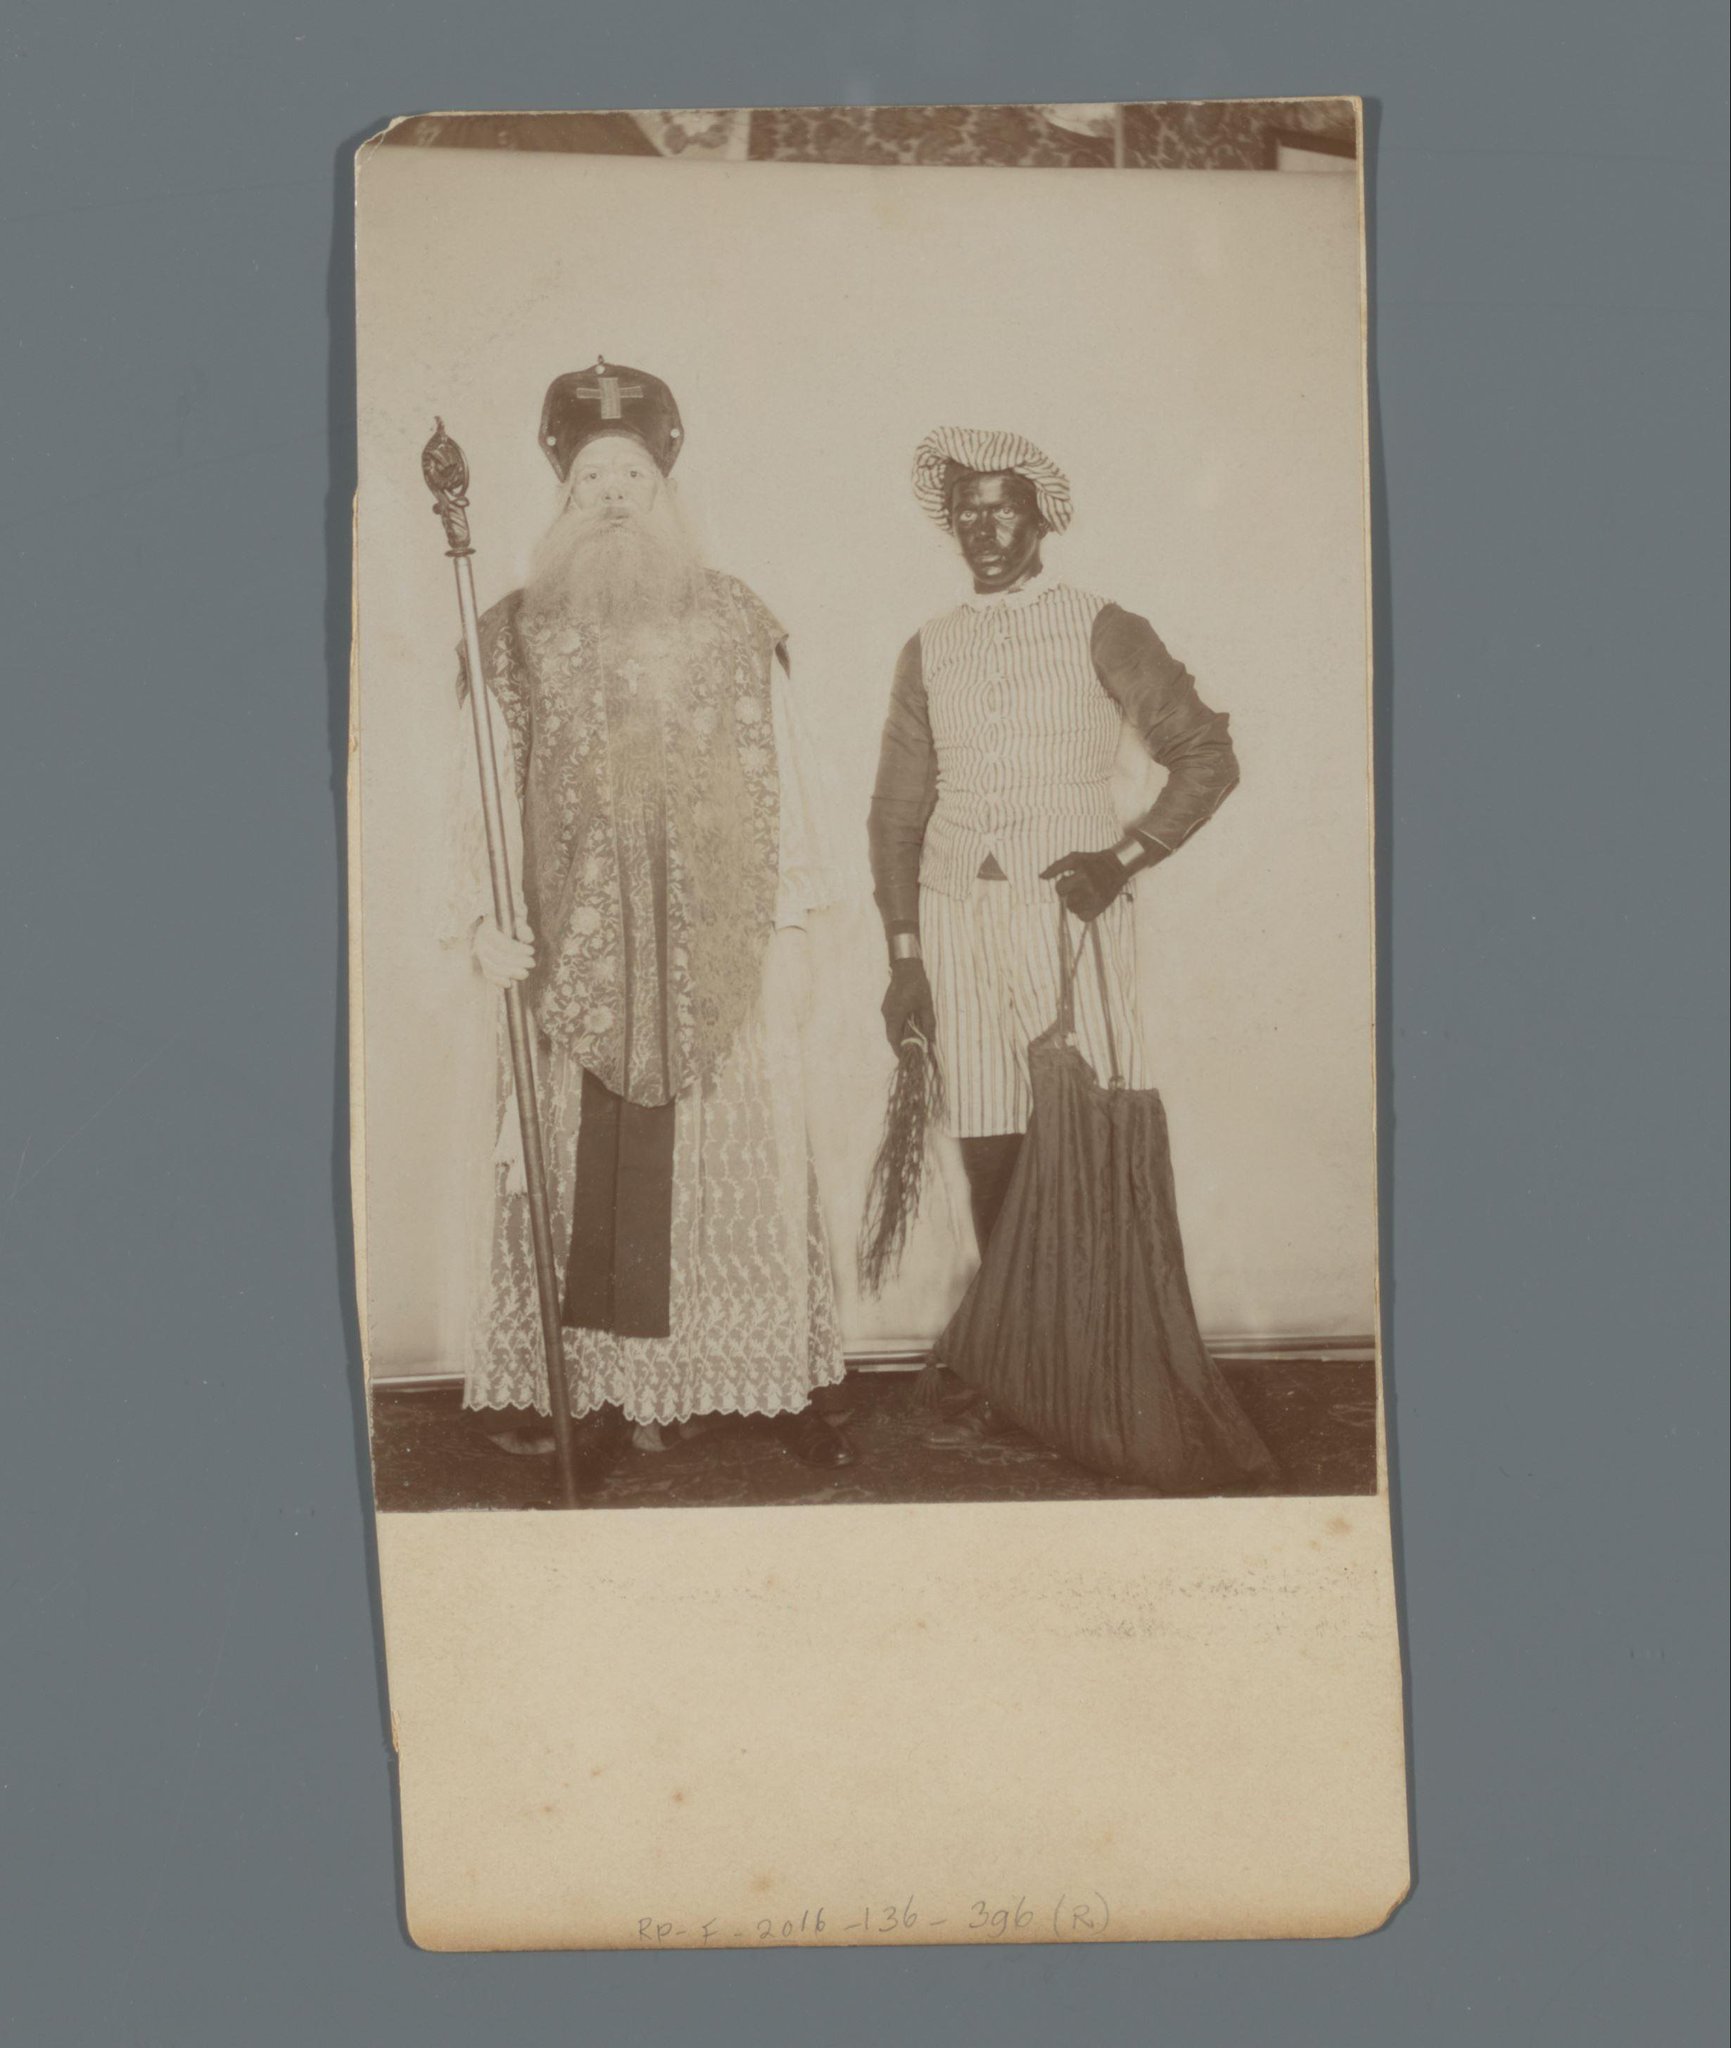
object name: photograph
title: Sinterklaas en Zwarte Piet, Turfmarkt 3, Amsterdam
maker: hendrik herman van den berg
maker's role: amateurfotograaf, jurist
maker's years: 1875-1944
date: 1890-1894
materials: cardboard, photographic support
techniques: collodion silver print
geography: amsterdam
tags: festivities on st. nicholas (eve) (december 5)